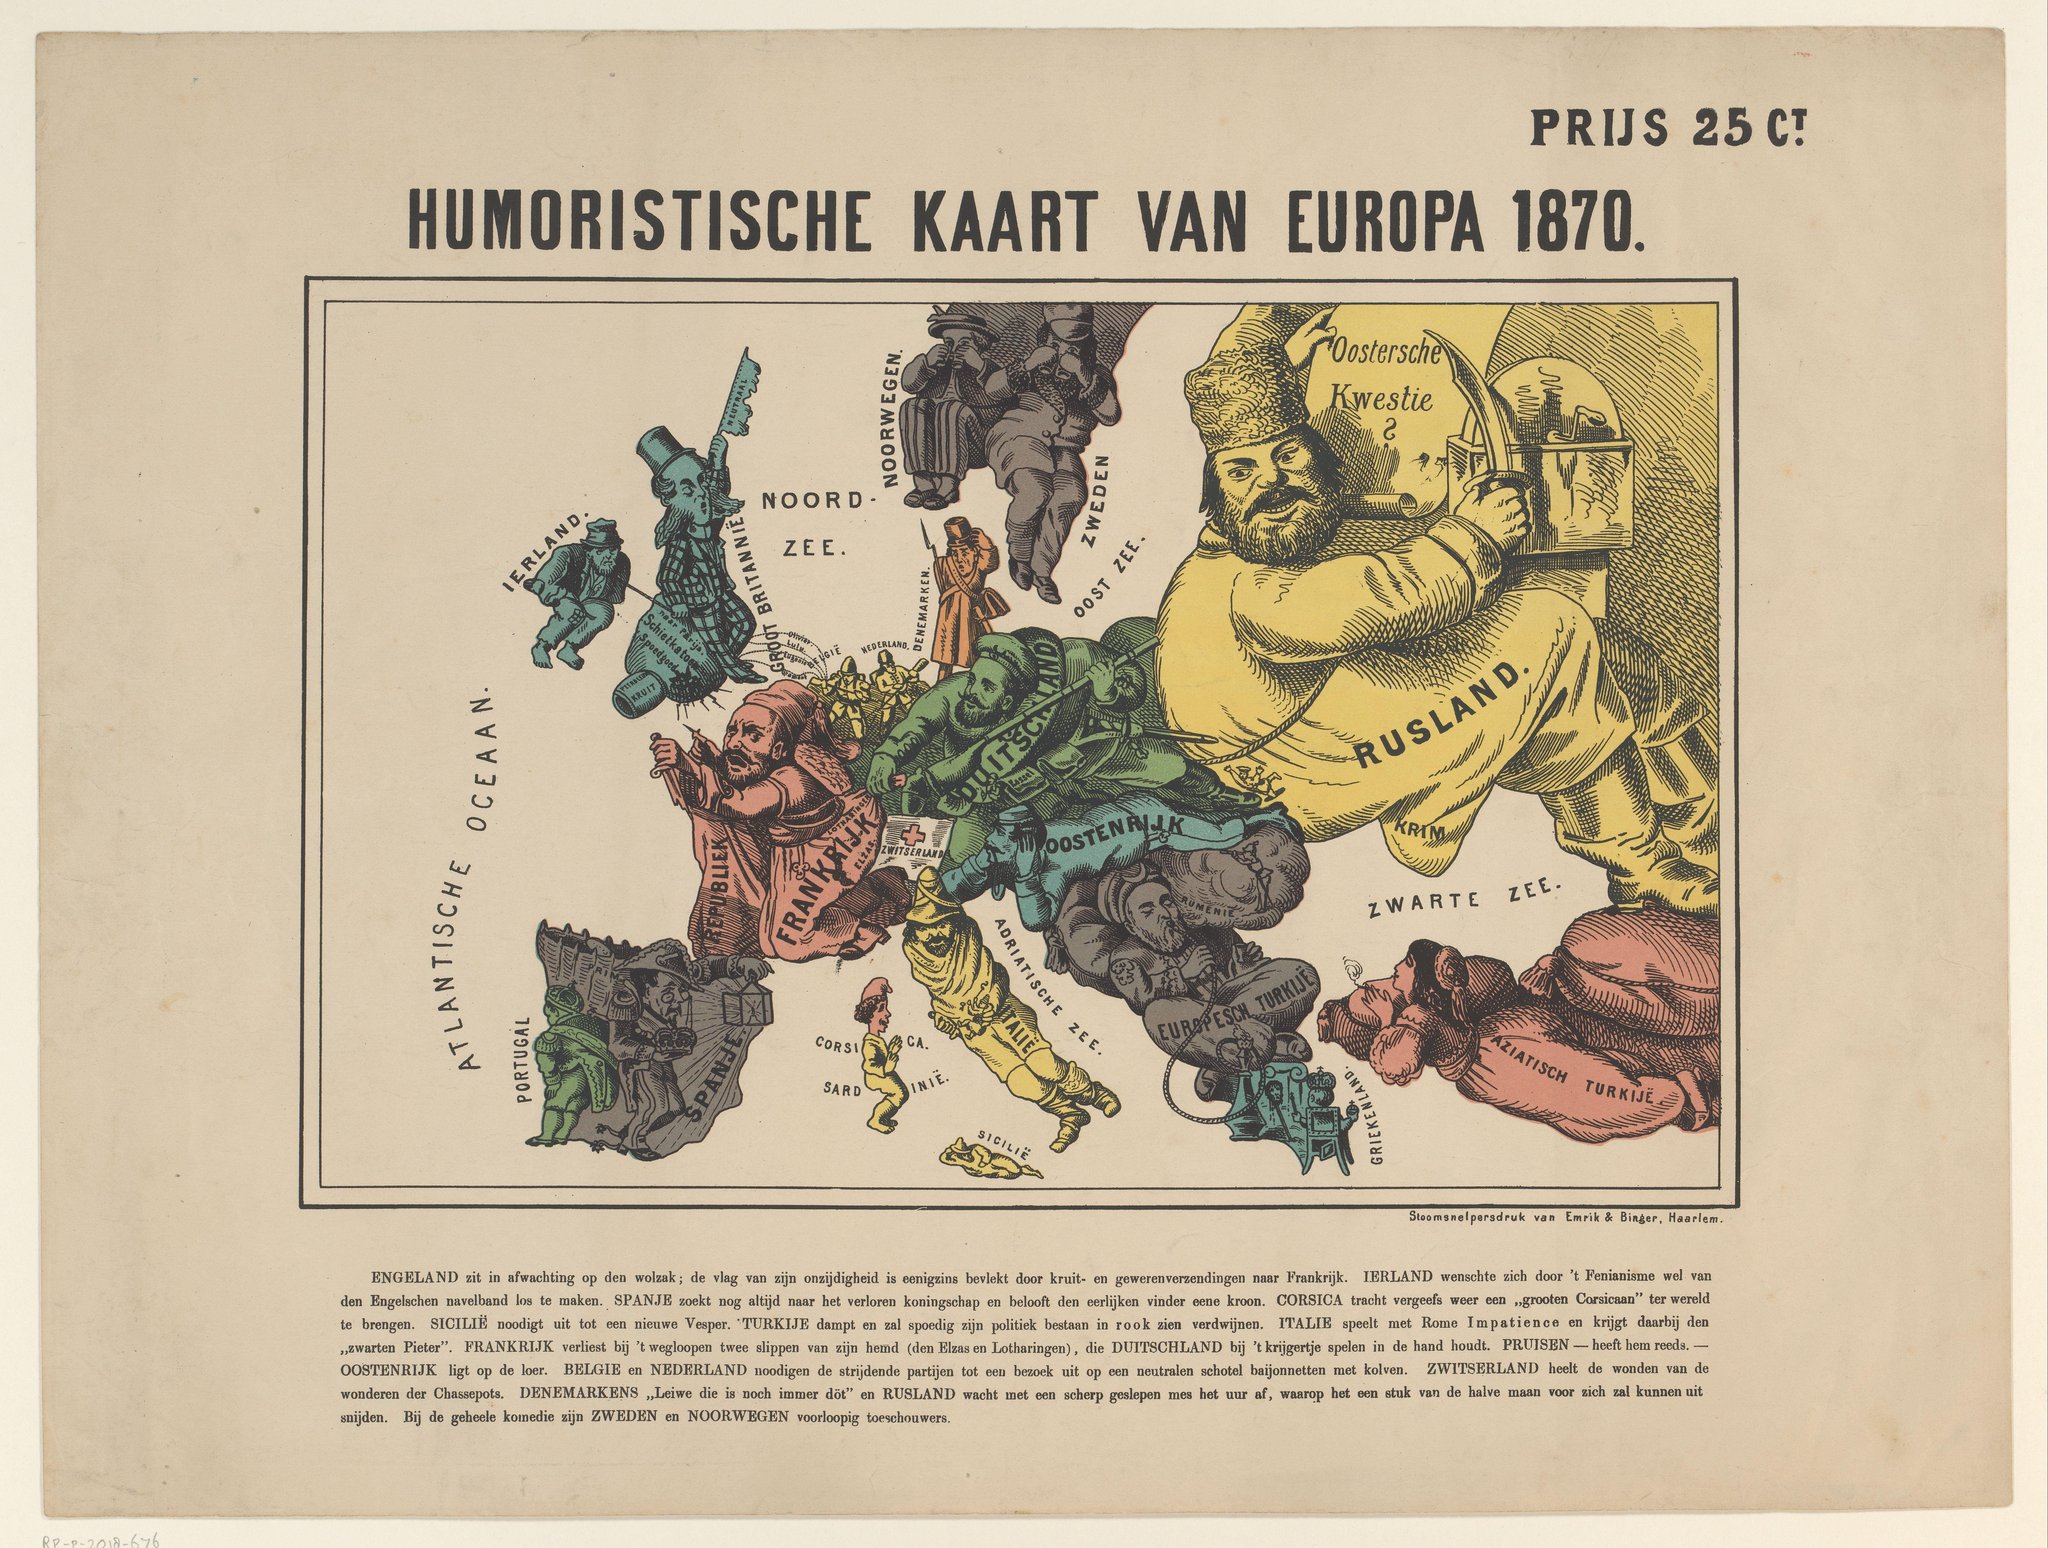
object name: cartoon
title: Humoristische kaart van Europa 1870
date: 1870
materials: paper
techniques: lithograph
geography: haarlem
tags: (map of) europe, europe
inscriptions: collector's mark: Lugt 2228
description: Spotprent met de kaart van Europa voorgesteld naar de politieke situatie in het jaar 1870. De landen weergegeven als personen en/of dieren. Met zevenregelige verklaring onder de voorstelling.